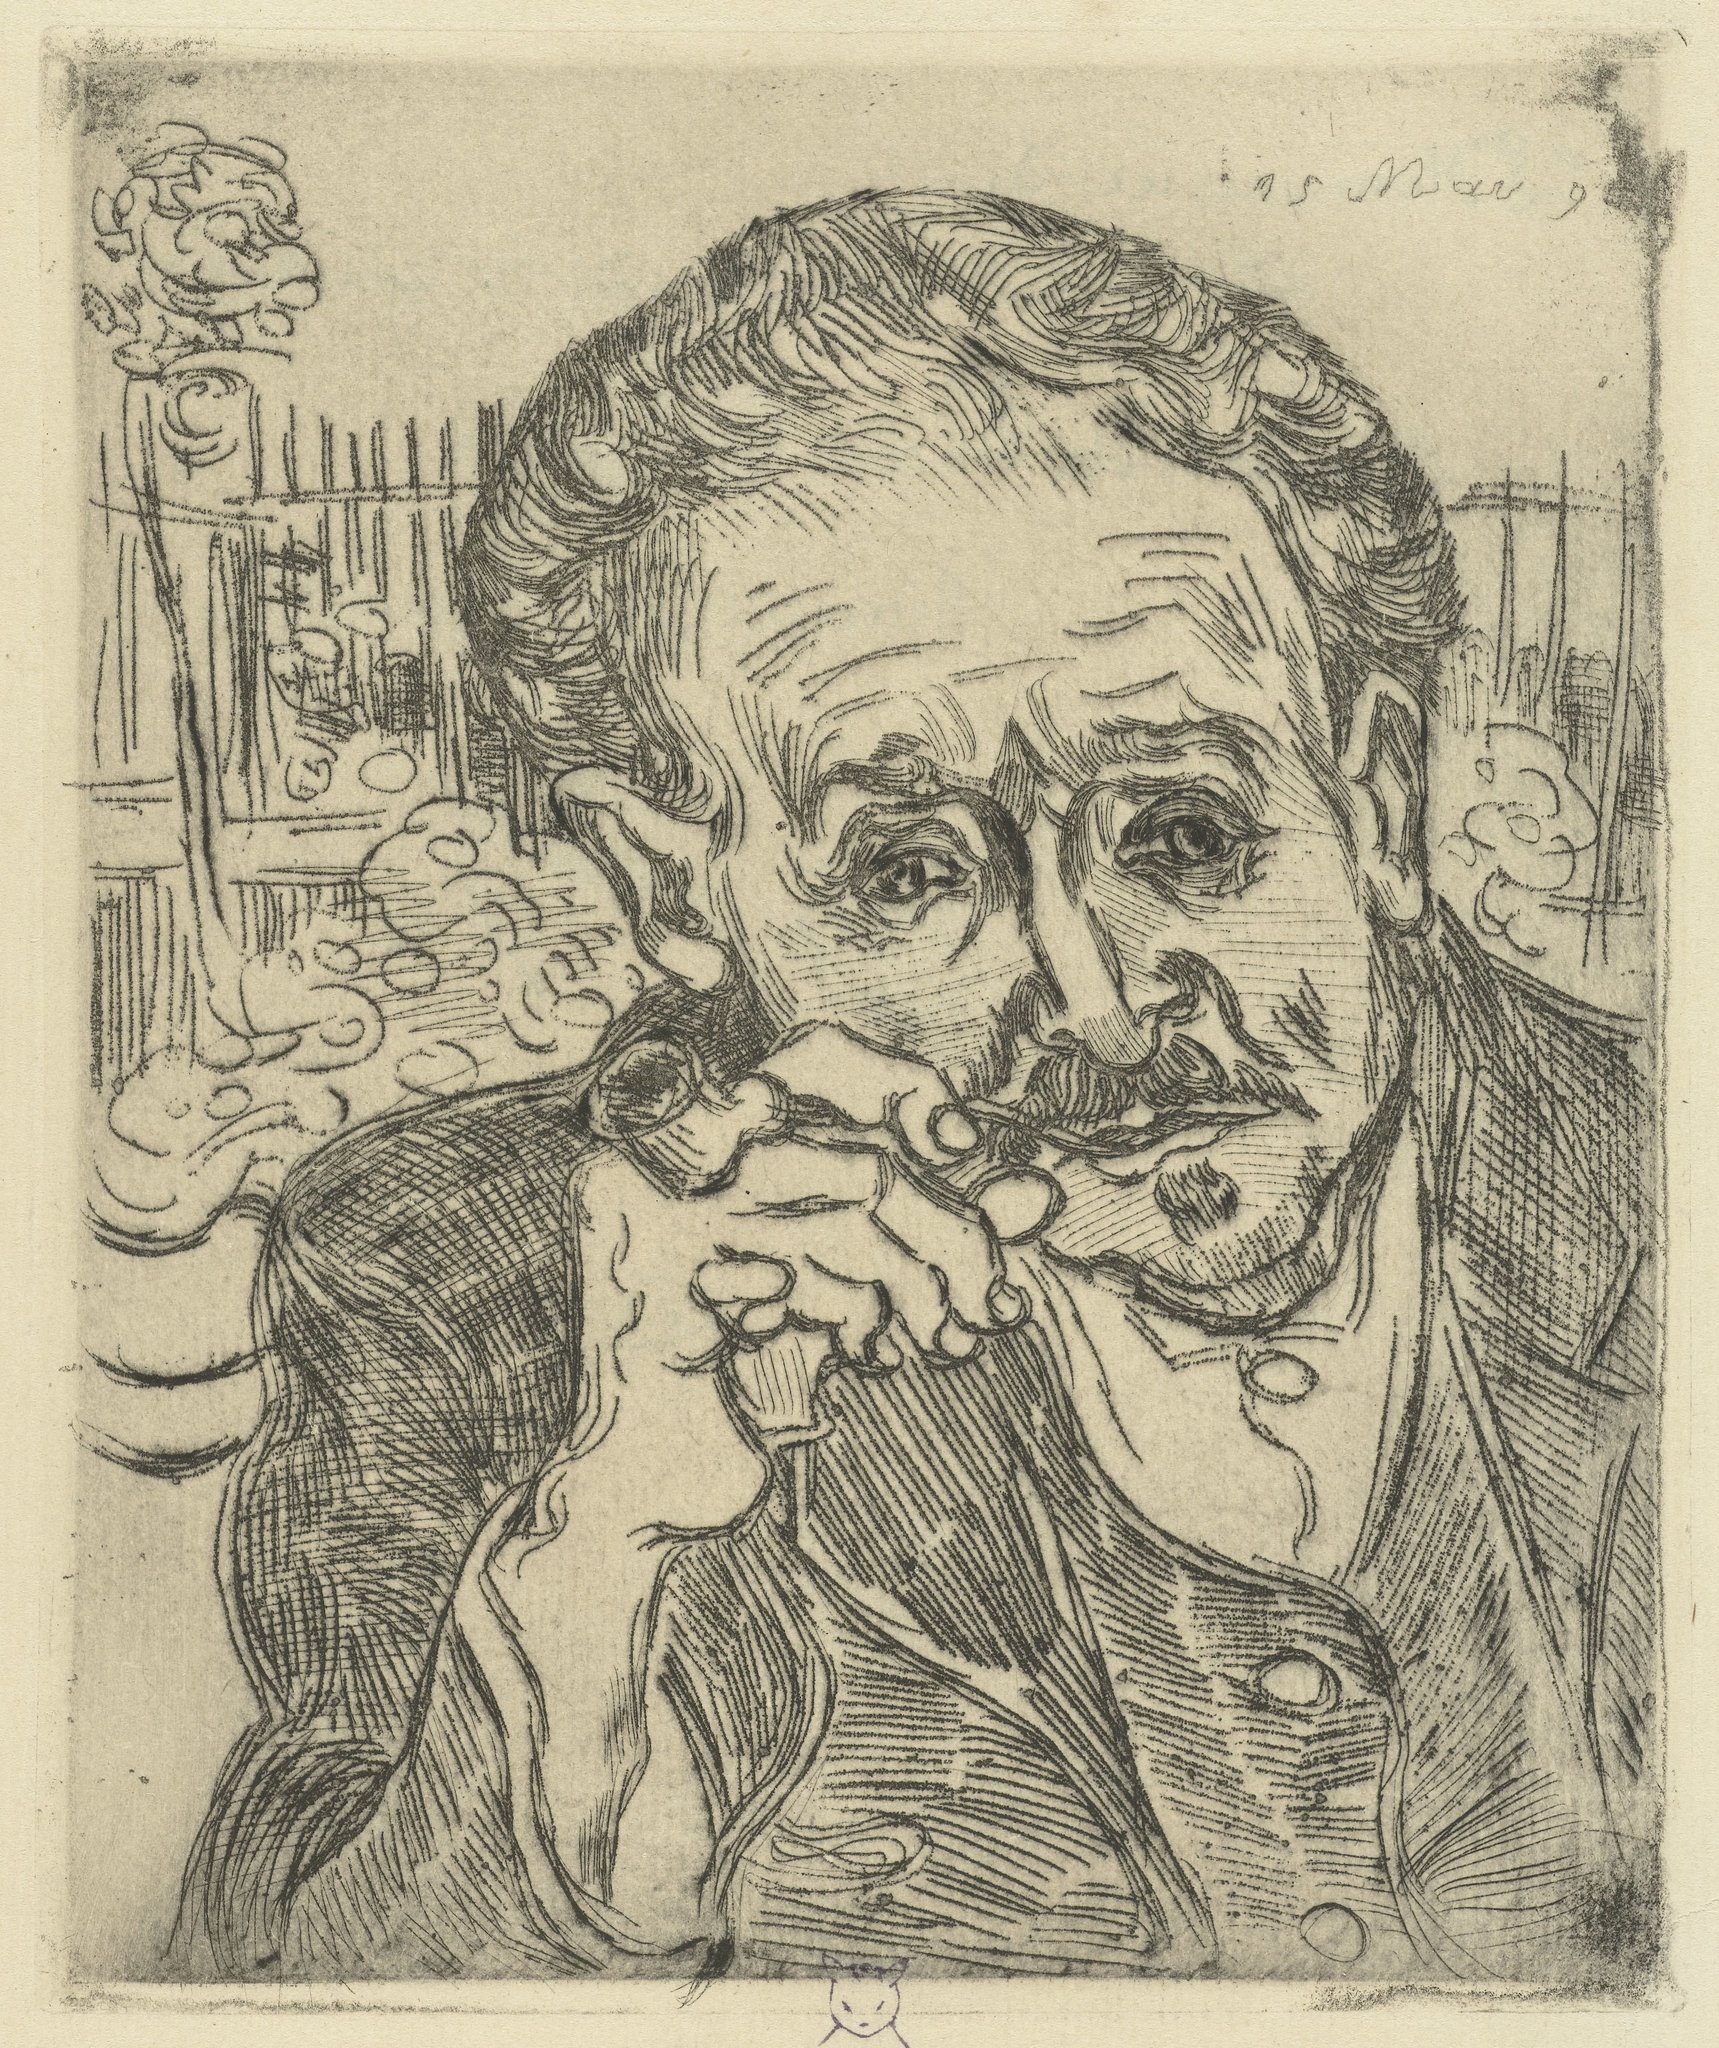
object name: print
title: Portrait of Dr Gachet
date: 1890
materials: paper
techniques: etching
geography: auvers-sur-oise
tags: lille, paul ferdinand gachet, historical persons, medicine, medical science (+ portrait of scholar, scientist)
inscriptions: collector's mark: Lugt 2760, inscription: ‘"L'Homme à la Pipe" / Portrait de mon Père (Le Dr. Gachet) / Eau-forte de Vincent Van Gogh / Auvers s/Oise - Mai 1890 / Paul Gachet'’, collector's mark: Lugt 2807c, collector's mark: Lugt 2228a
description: This small print showcases Van Gogh’s skill in yet another printmaking process. Dr Gachet in Auvers, whom Van Gogh had been seeing after moving from the south of France, had an etching press. This tempted Van Gogh to try his hand at this difficult technique. It turned out to be a wonderful portrait of the doctor, but unfortunately it is the only etching he ever made.